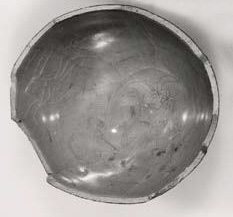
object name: shard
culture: korean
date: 1101-1200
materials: pottery